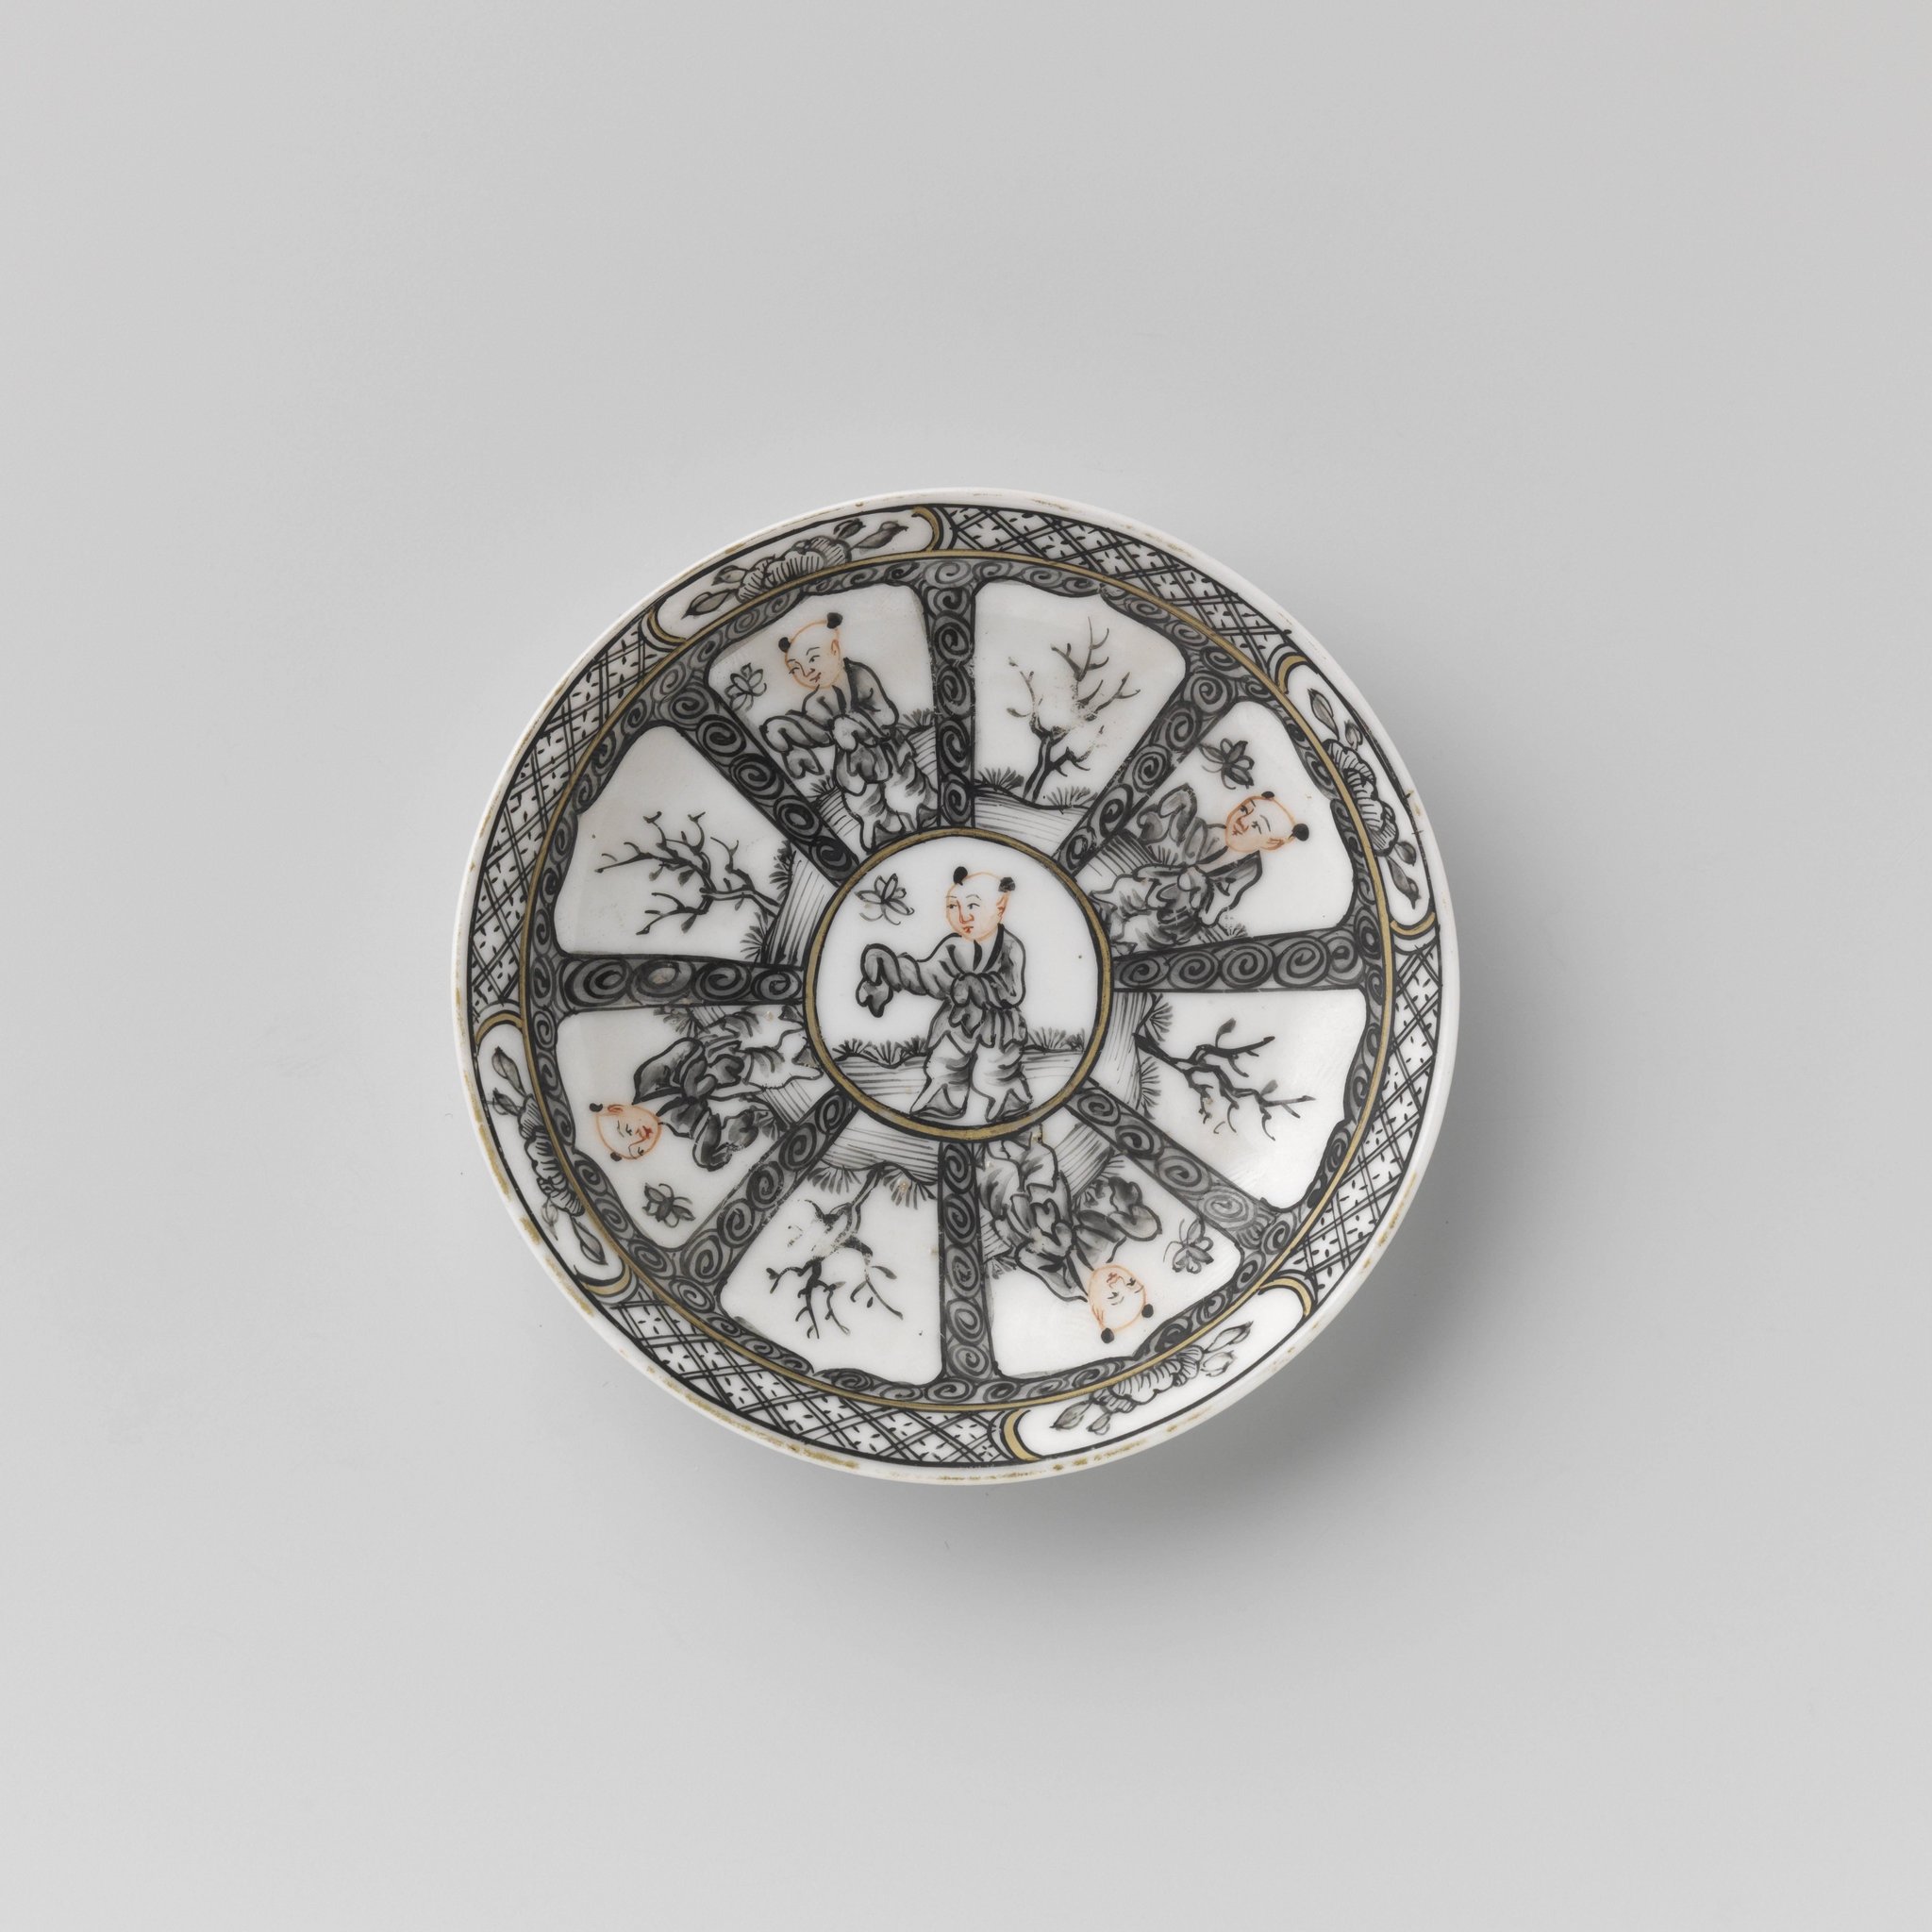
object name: kop en schotel, kop en schotel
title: Schotel with a boy and a butterfly in a landscape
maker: Anonymous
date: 1725-1749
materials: glaze, gold, paint, porcelain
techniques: firing, gilding, turning, vitrification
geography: china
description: Kop en schotel, in zwart ,rose en goud met chinezen en bomen in perken.